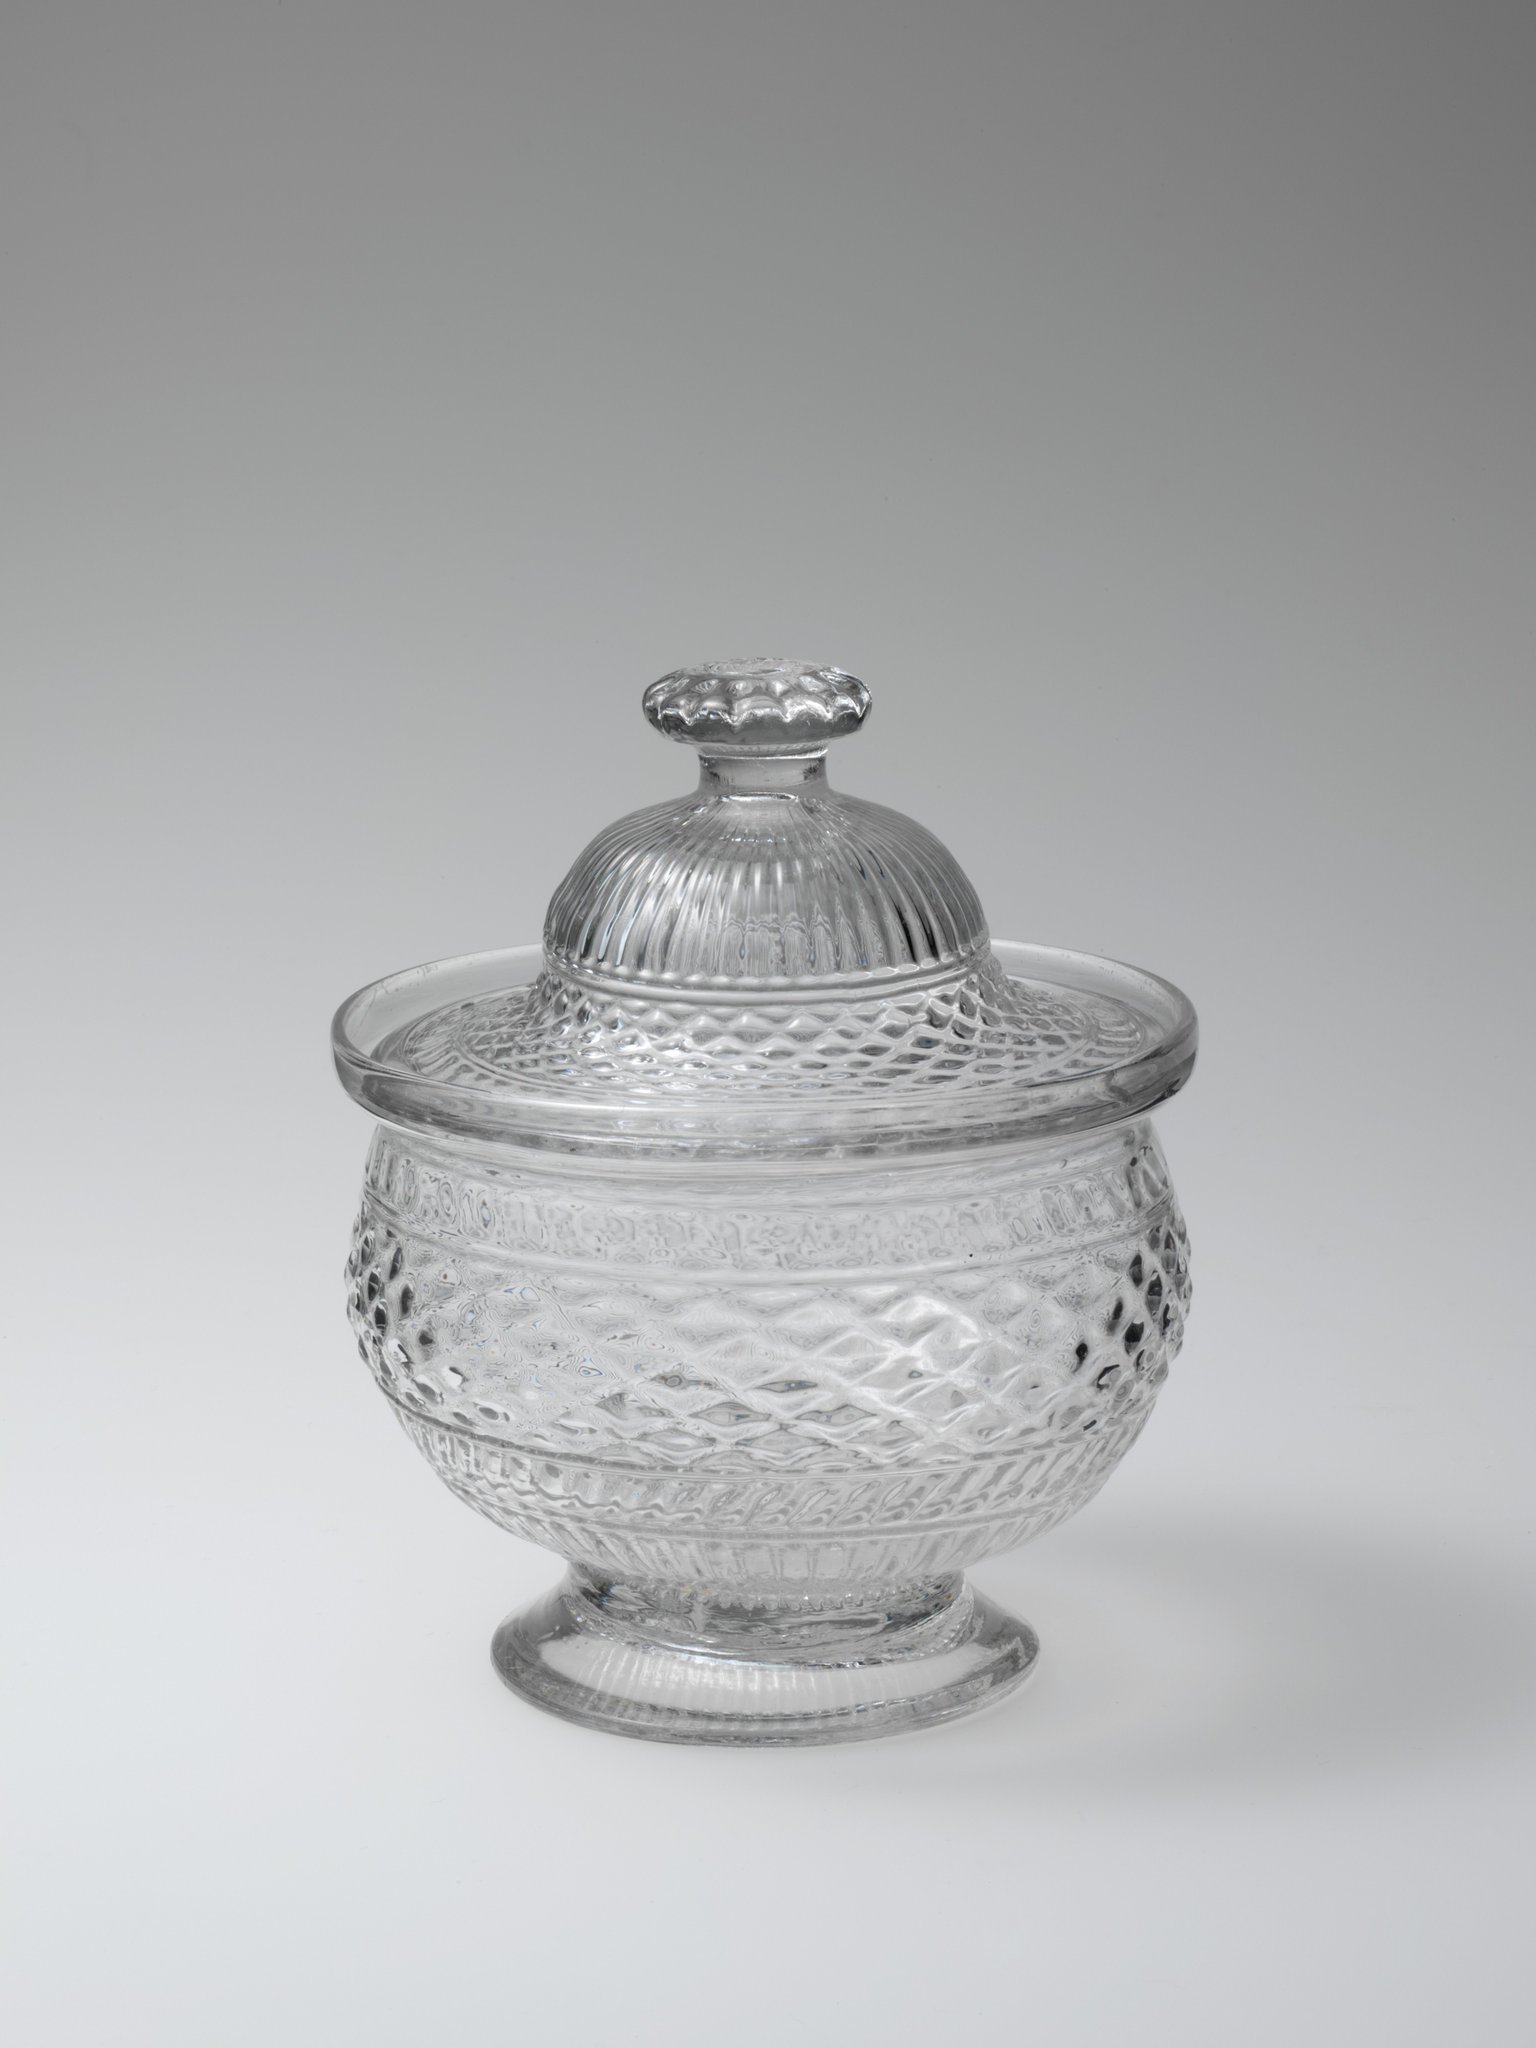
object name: sugar bowl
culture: american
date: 1825-1840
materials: glass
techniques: glassblowing, molding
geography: united states